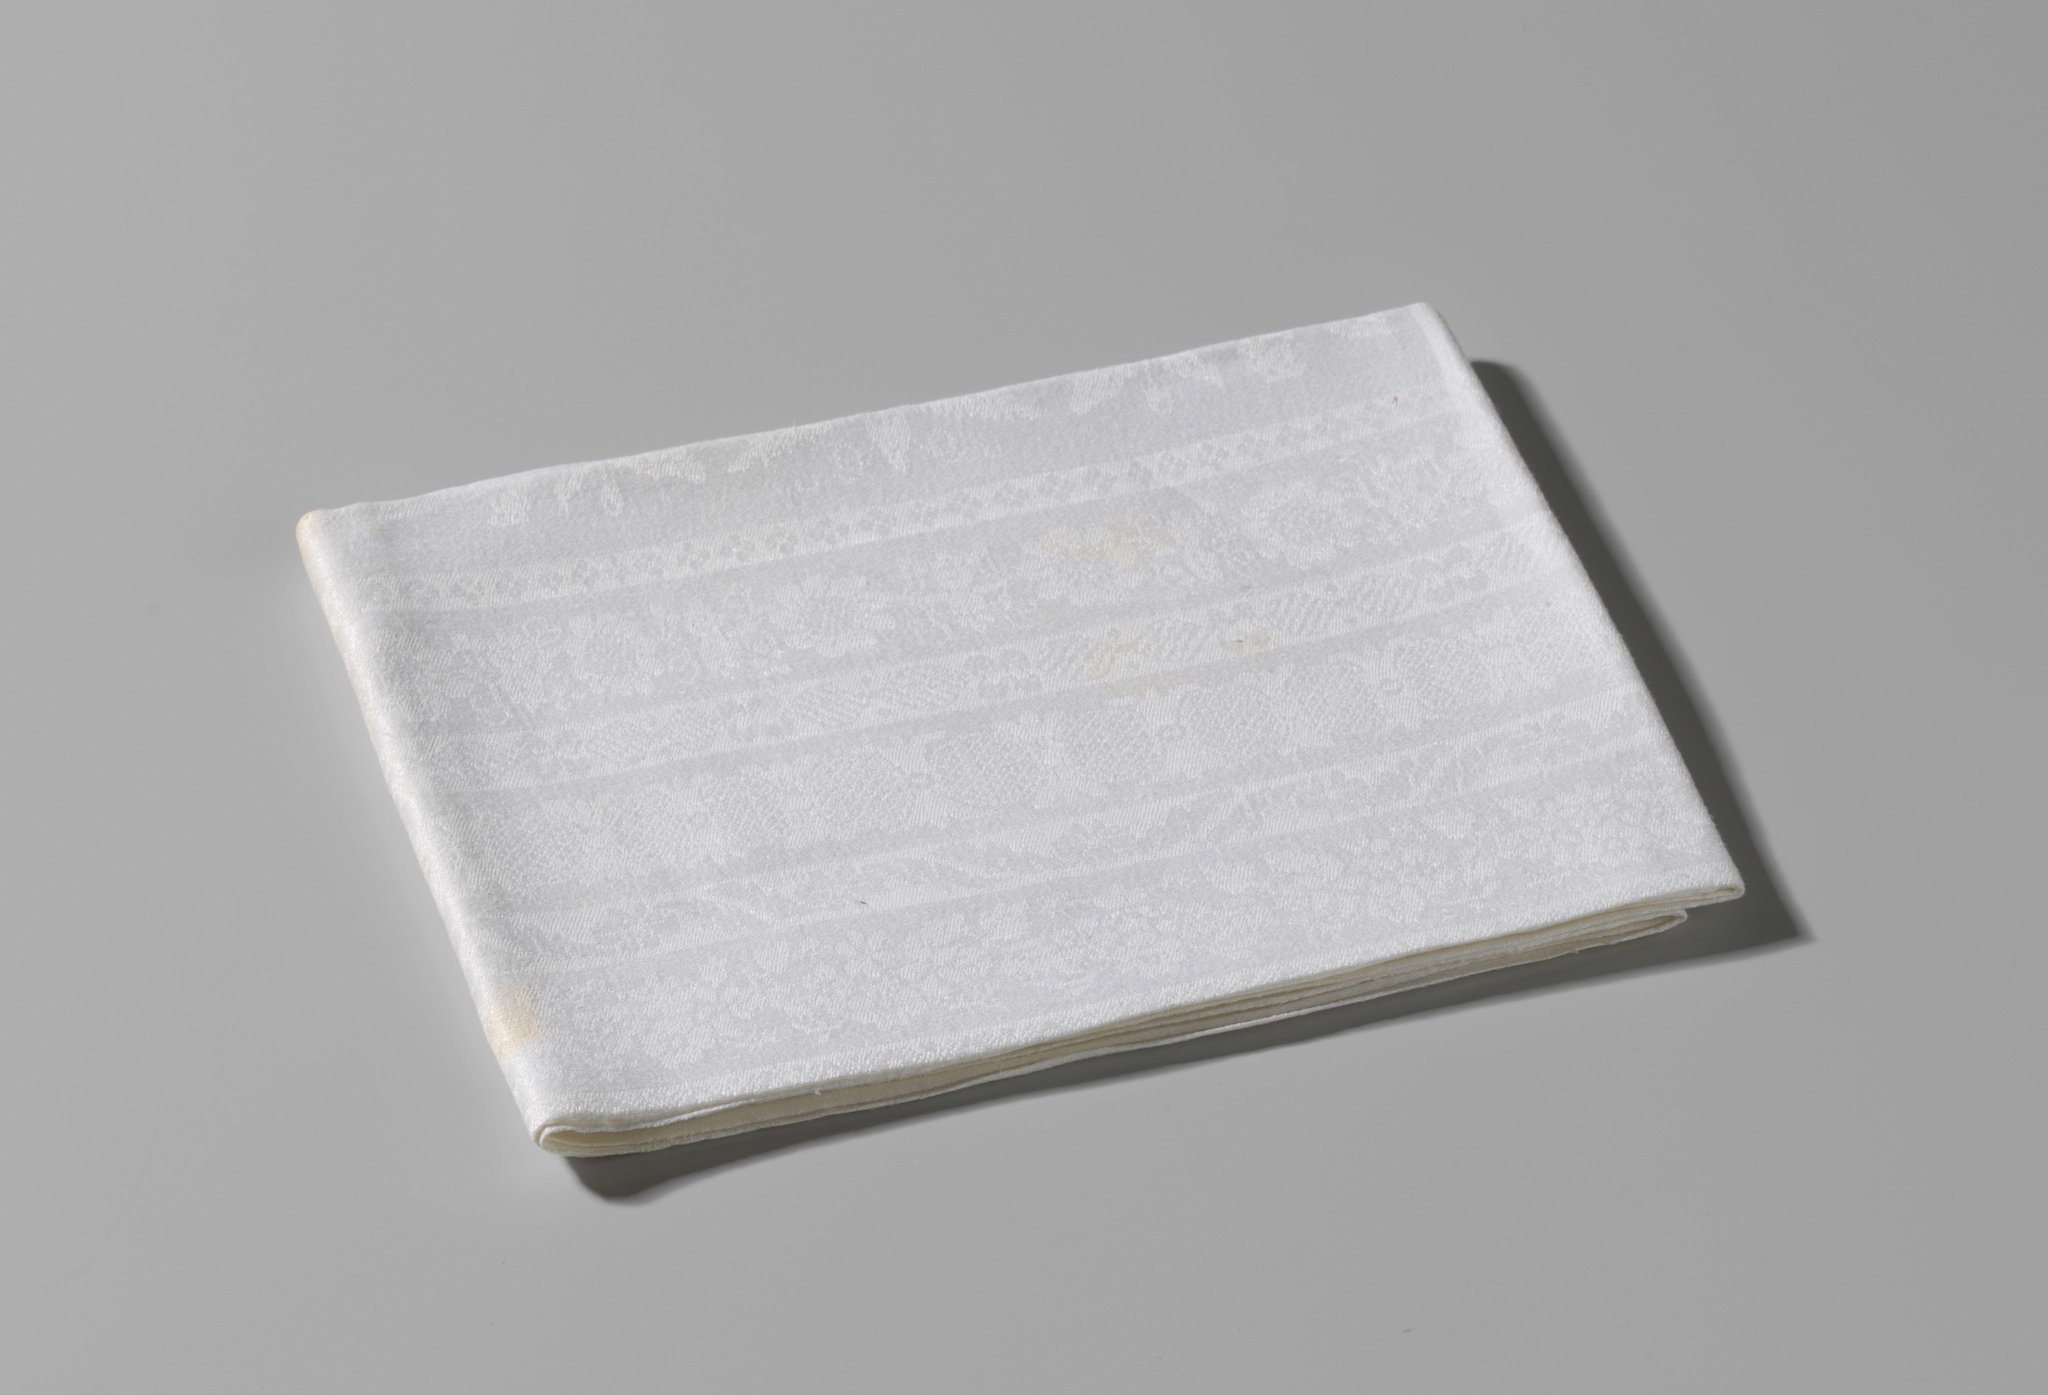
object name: napkin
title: Servet van damast met geornamenteerde lengtestrepen binnen een rand met voluten, bloemen en een bloemenmand.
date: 1840-1860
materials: linen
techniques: damask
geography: netherlands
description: Wit linnen damasten servet met geornamenteerde lengtestrepen binnen een rand met voluten, bloemen en een bloemenmand. Gemerkt: WdW en 24.